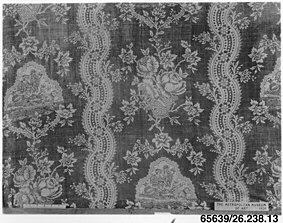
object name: floral print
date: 1820-1825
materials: linen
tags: roses